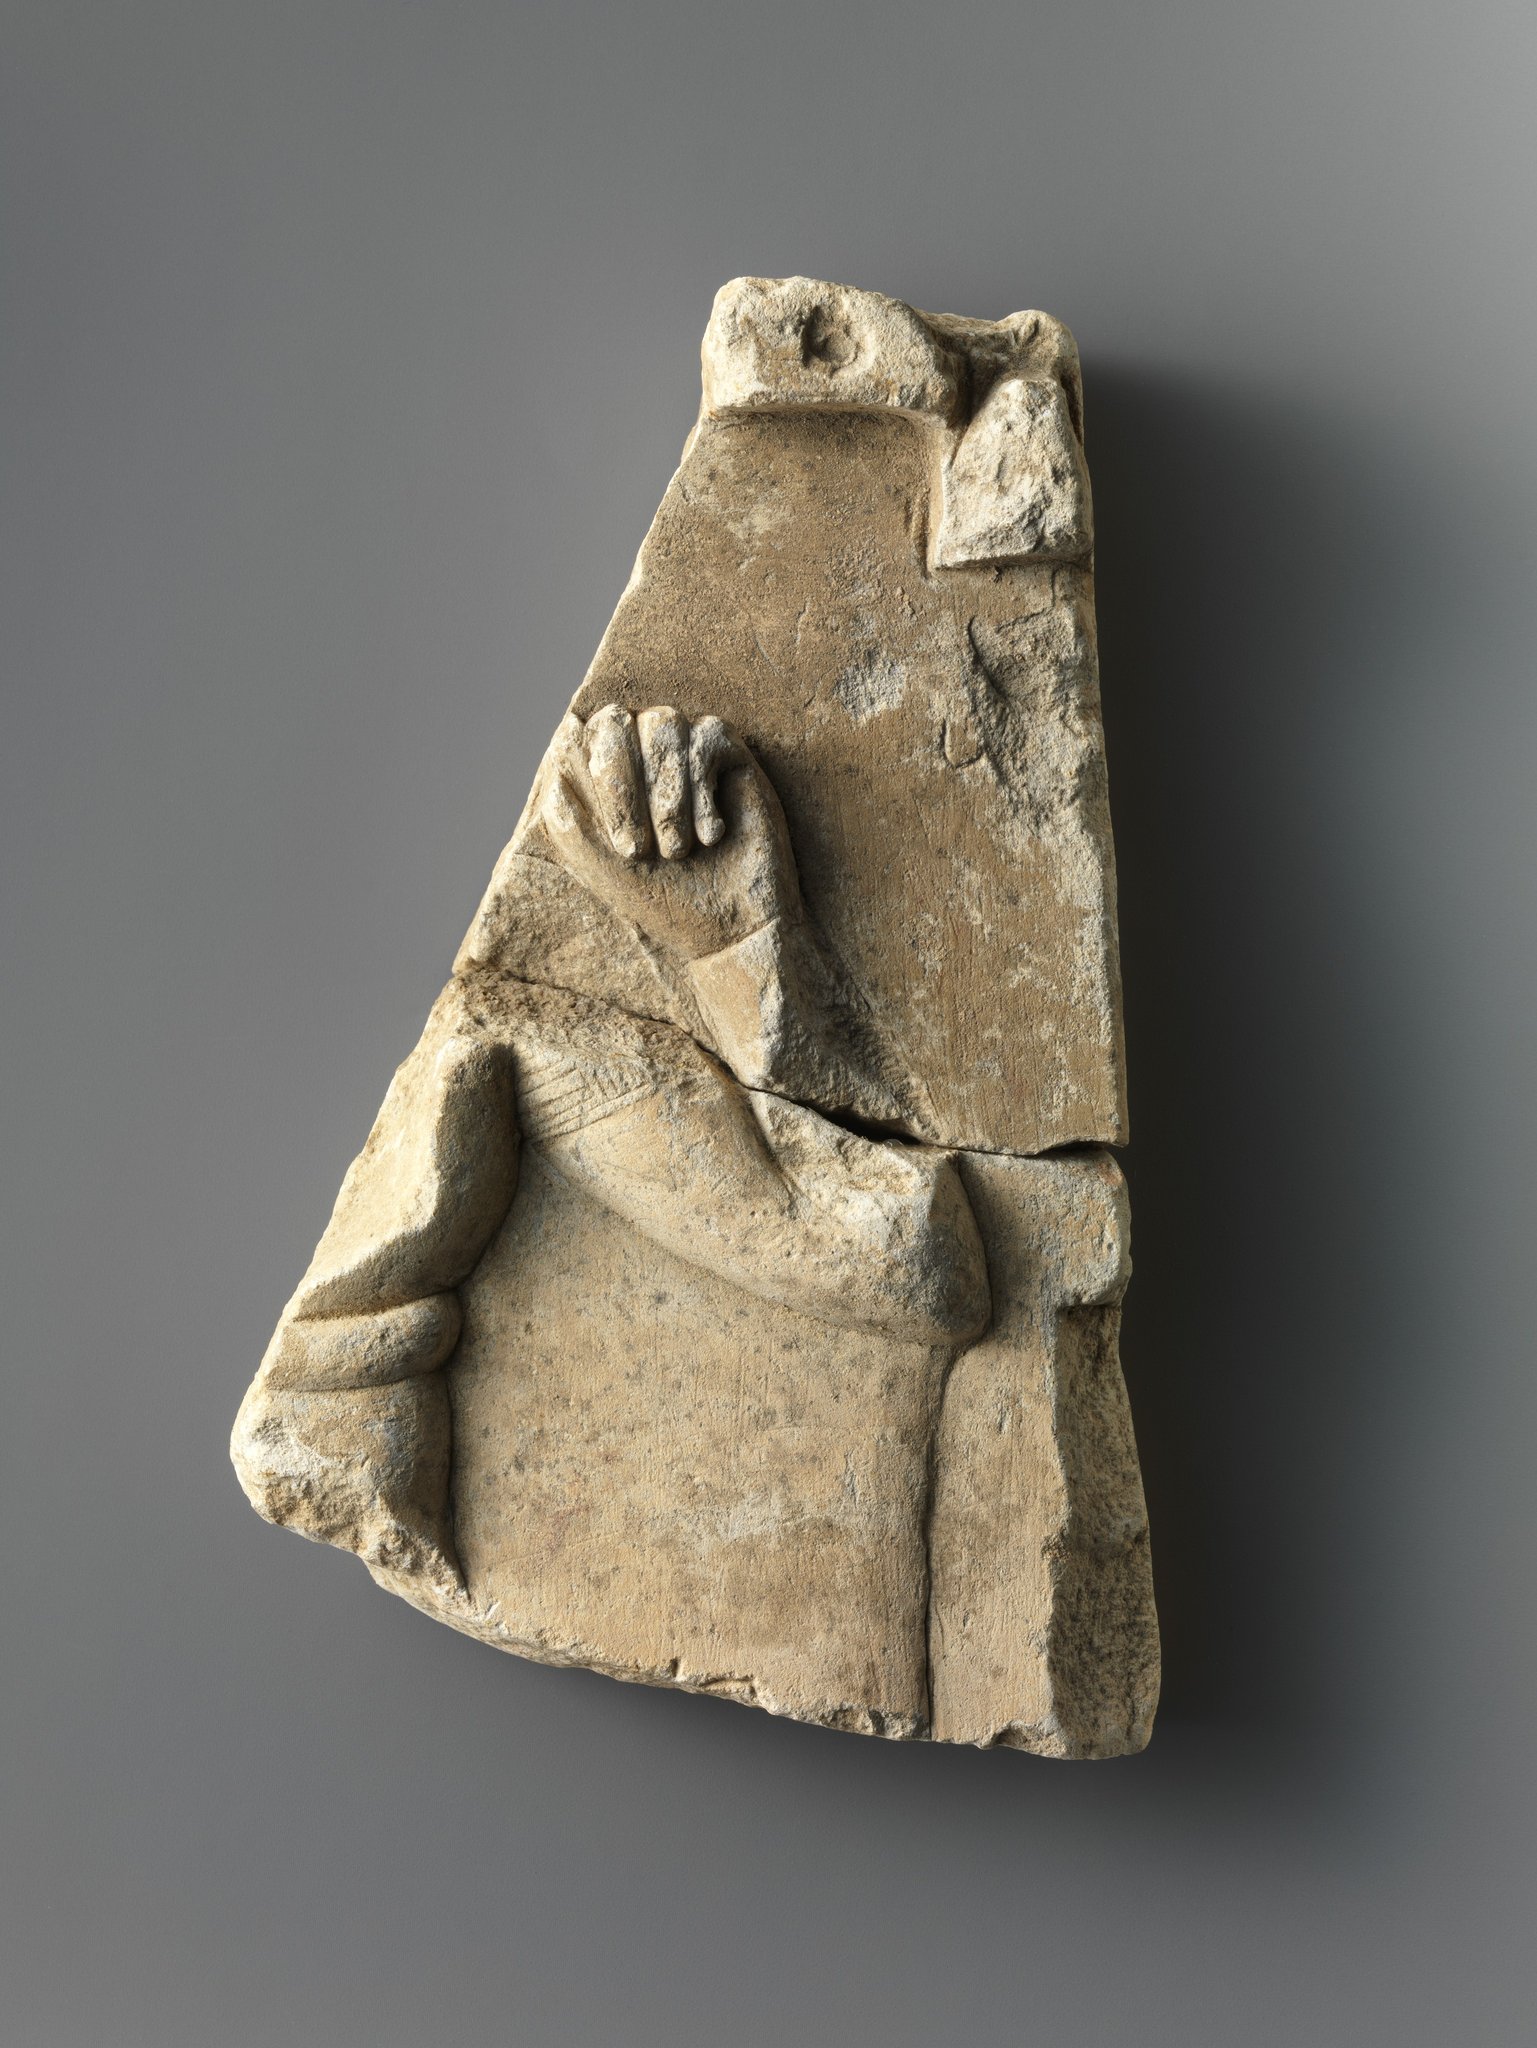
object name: sculptor's model votive, fragment, child, god, inscribed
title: Fragment of relief plaque with a child god, inscribed on reverse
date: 500-200 BCE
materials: limestone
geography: egypt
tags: hands